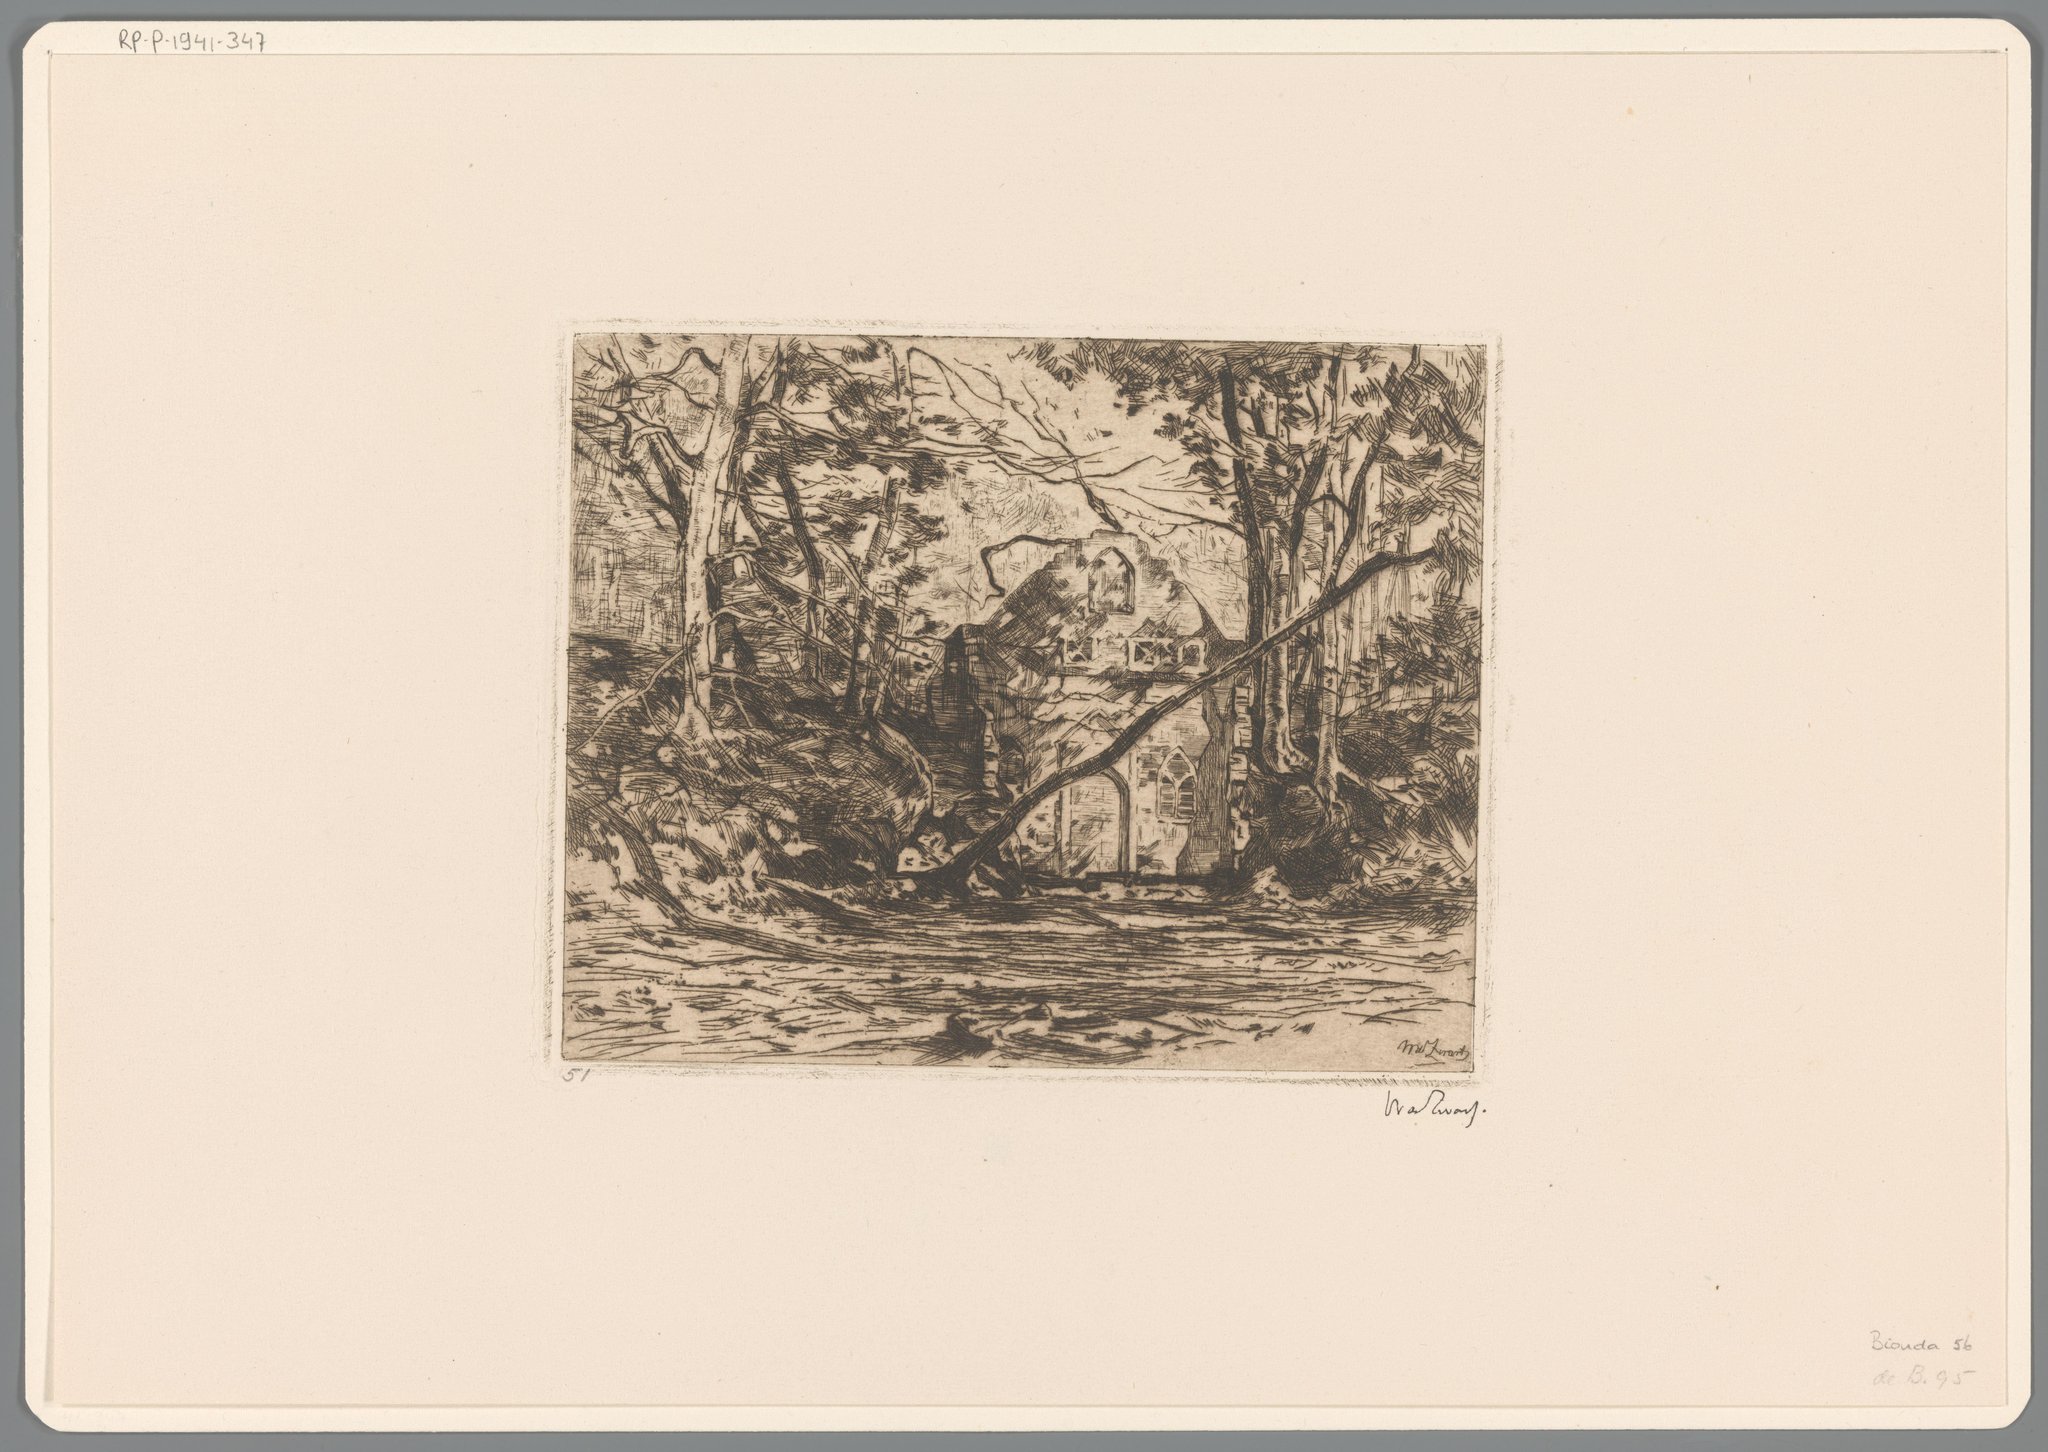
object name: print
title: Ruïne met ontwortelde boom (Lage Vuursche)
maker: willem de zwart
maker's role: draughtsman, painter, print maker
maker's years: 1862-1931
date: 1896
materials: paper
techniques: etching, intaglio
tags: landscape with ruins, forest, wood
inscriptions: collector's mark: Lugt 2760, collector's mark: Lugt 2228